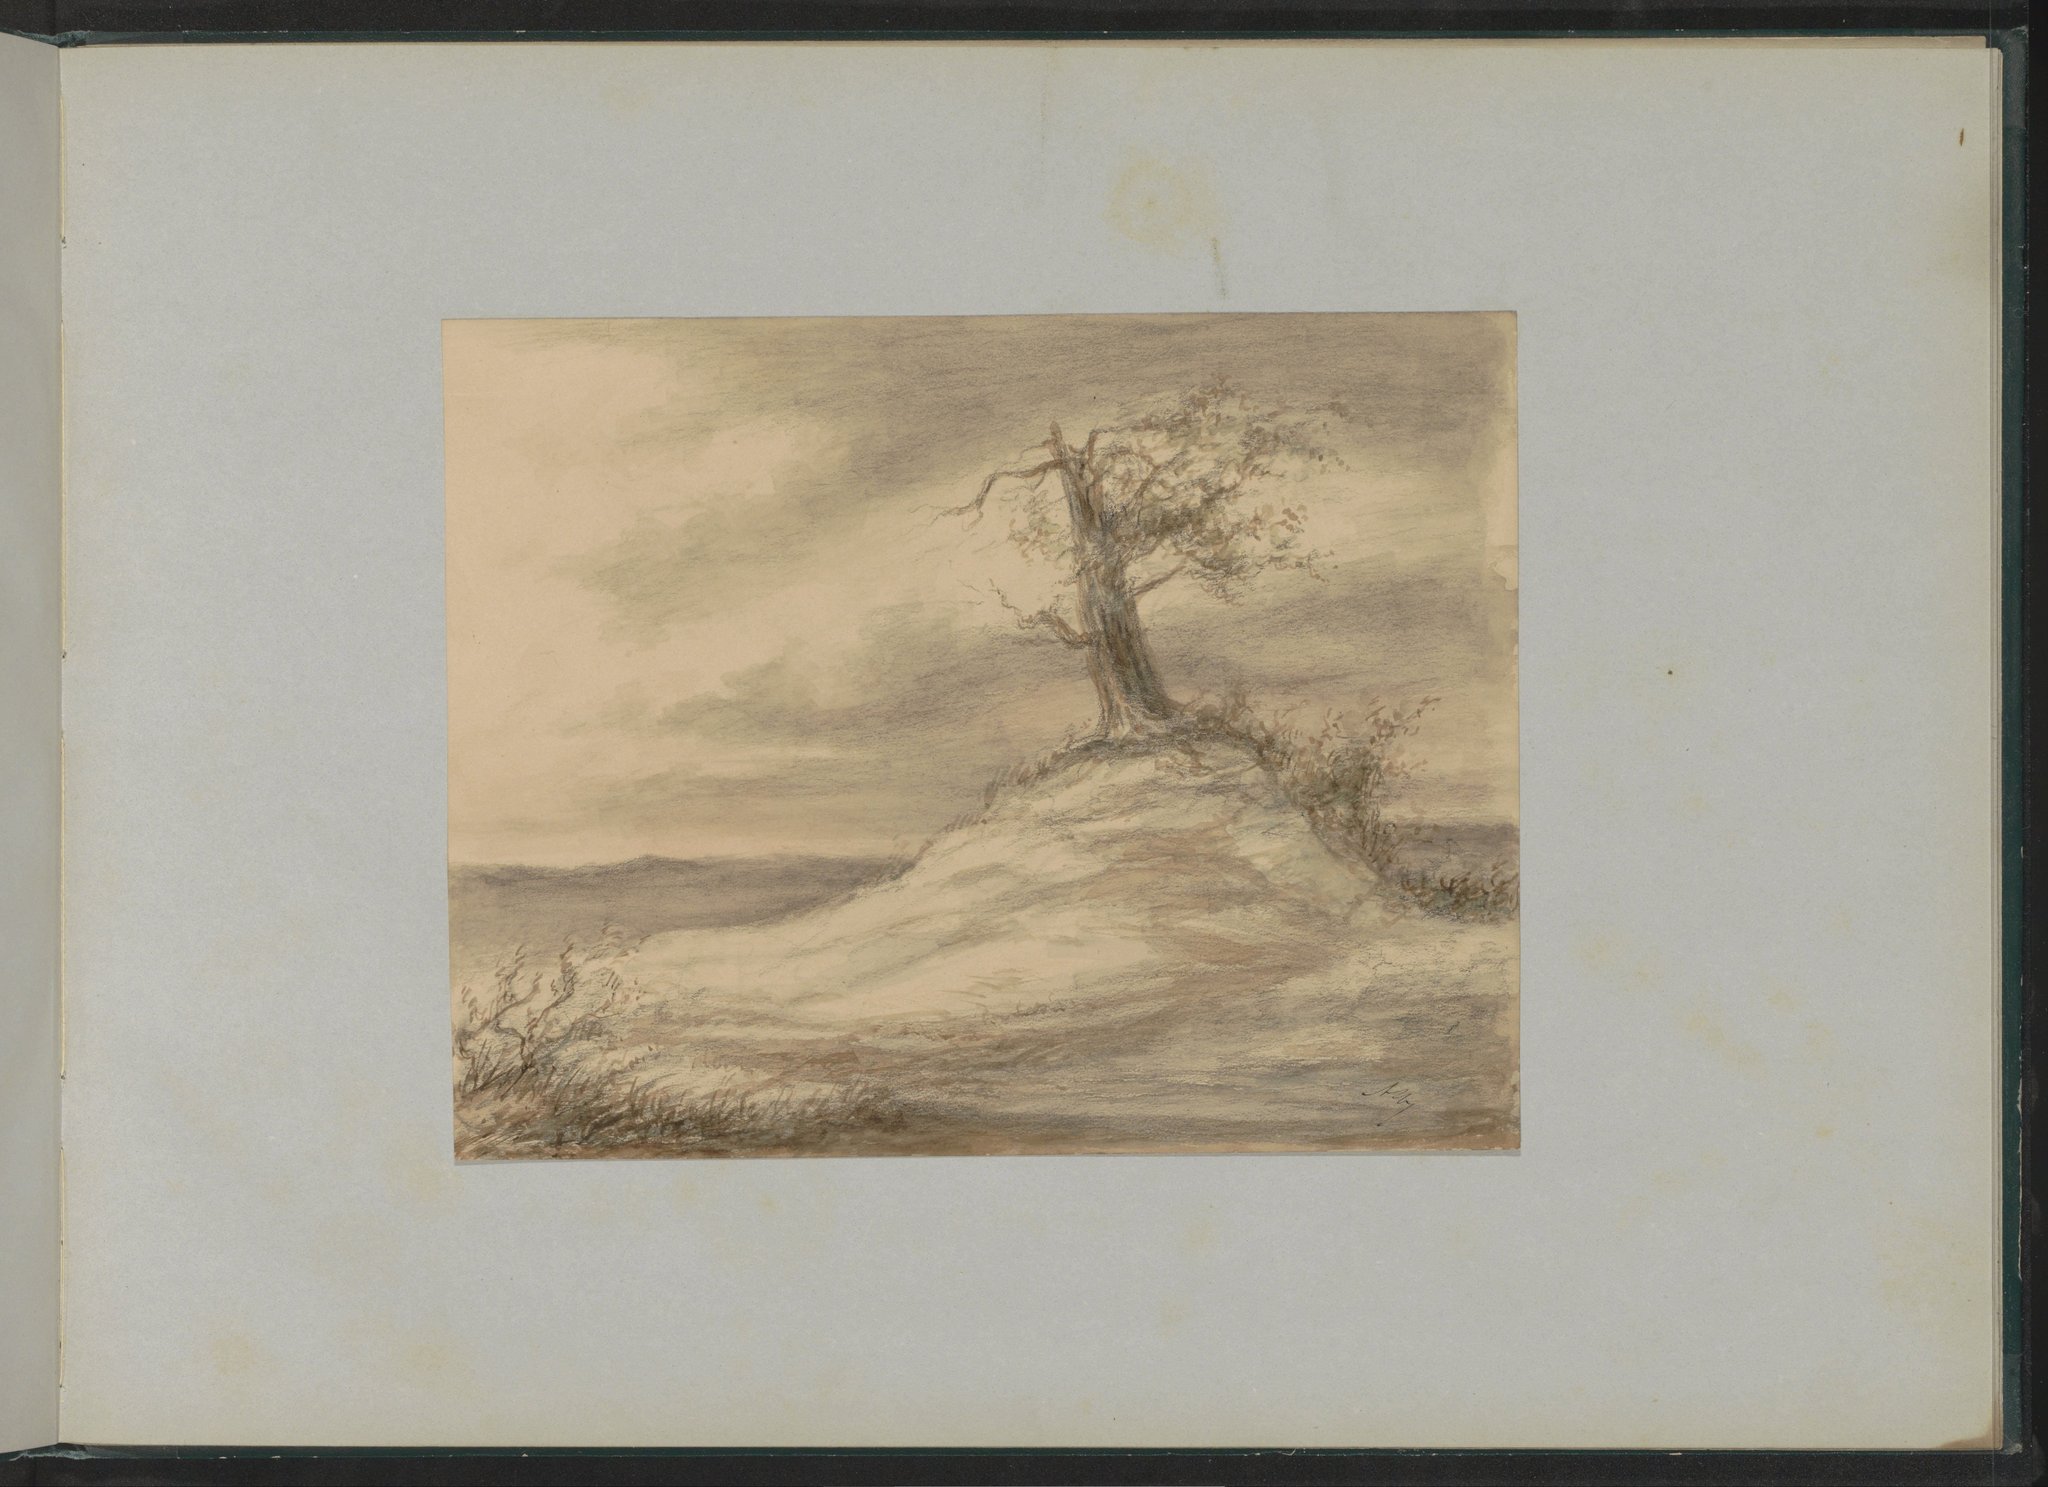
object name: drawing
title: Boom op een heuvel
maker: alexander ver huell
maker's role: draughtsman, print maker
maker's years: 1822-1897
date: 1854-1887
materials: paper, pencil, watercolor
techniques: brush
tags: trees, (high) hill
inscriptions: signature: ‘Avh’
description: Recto van de tekening op blad 28 van een album met 35 tekeningen.